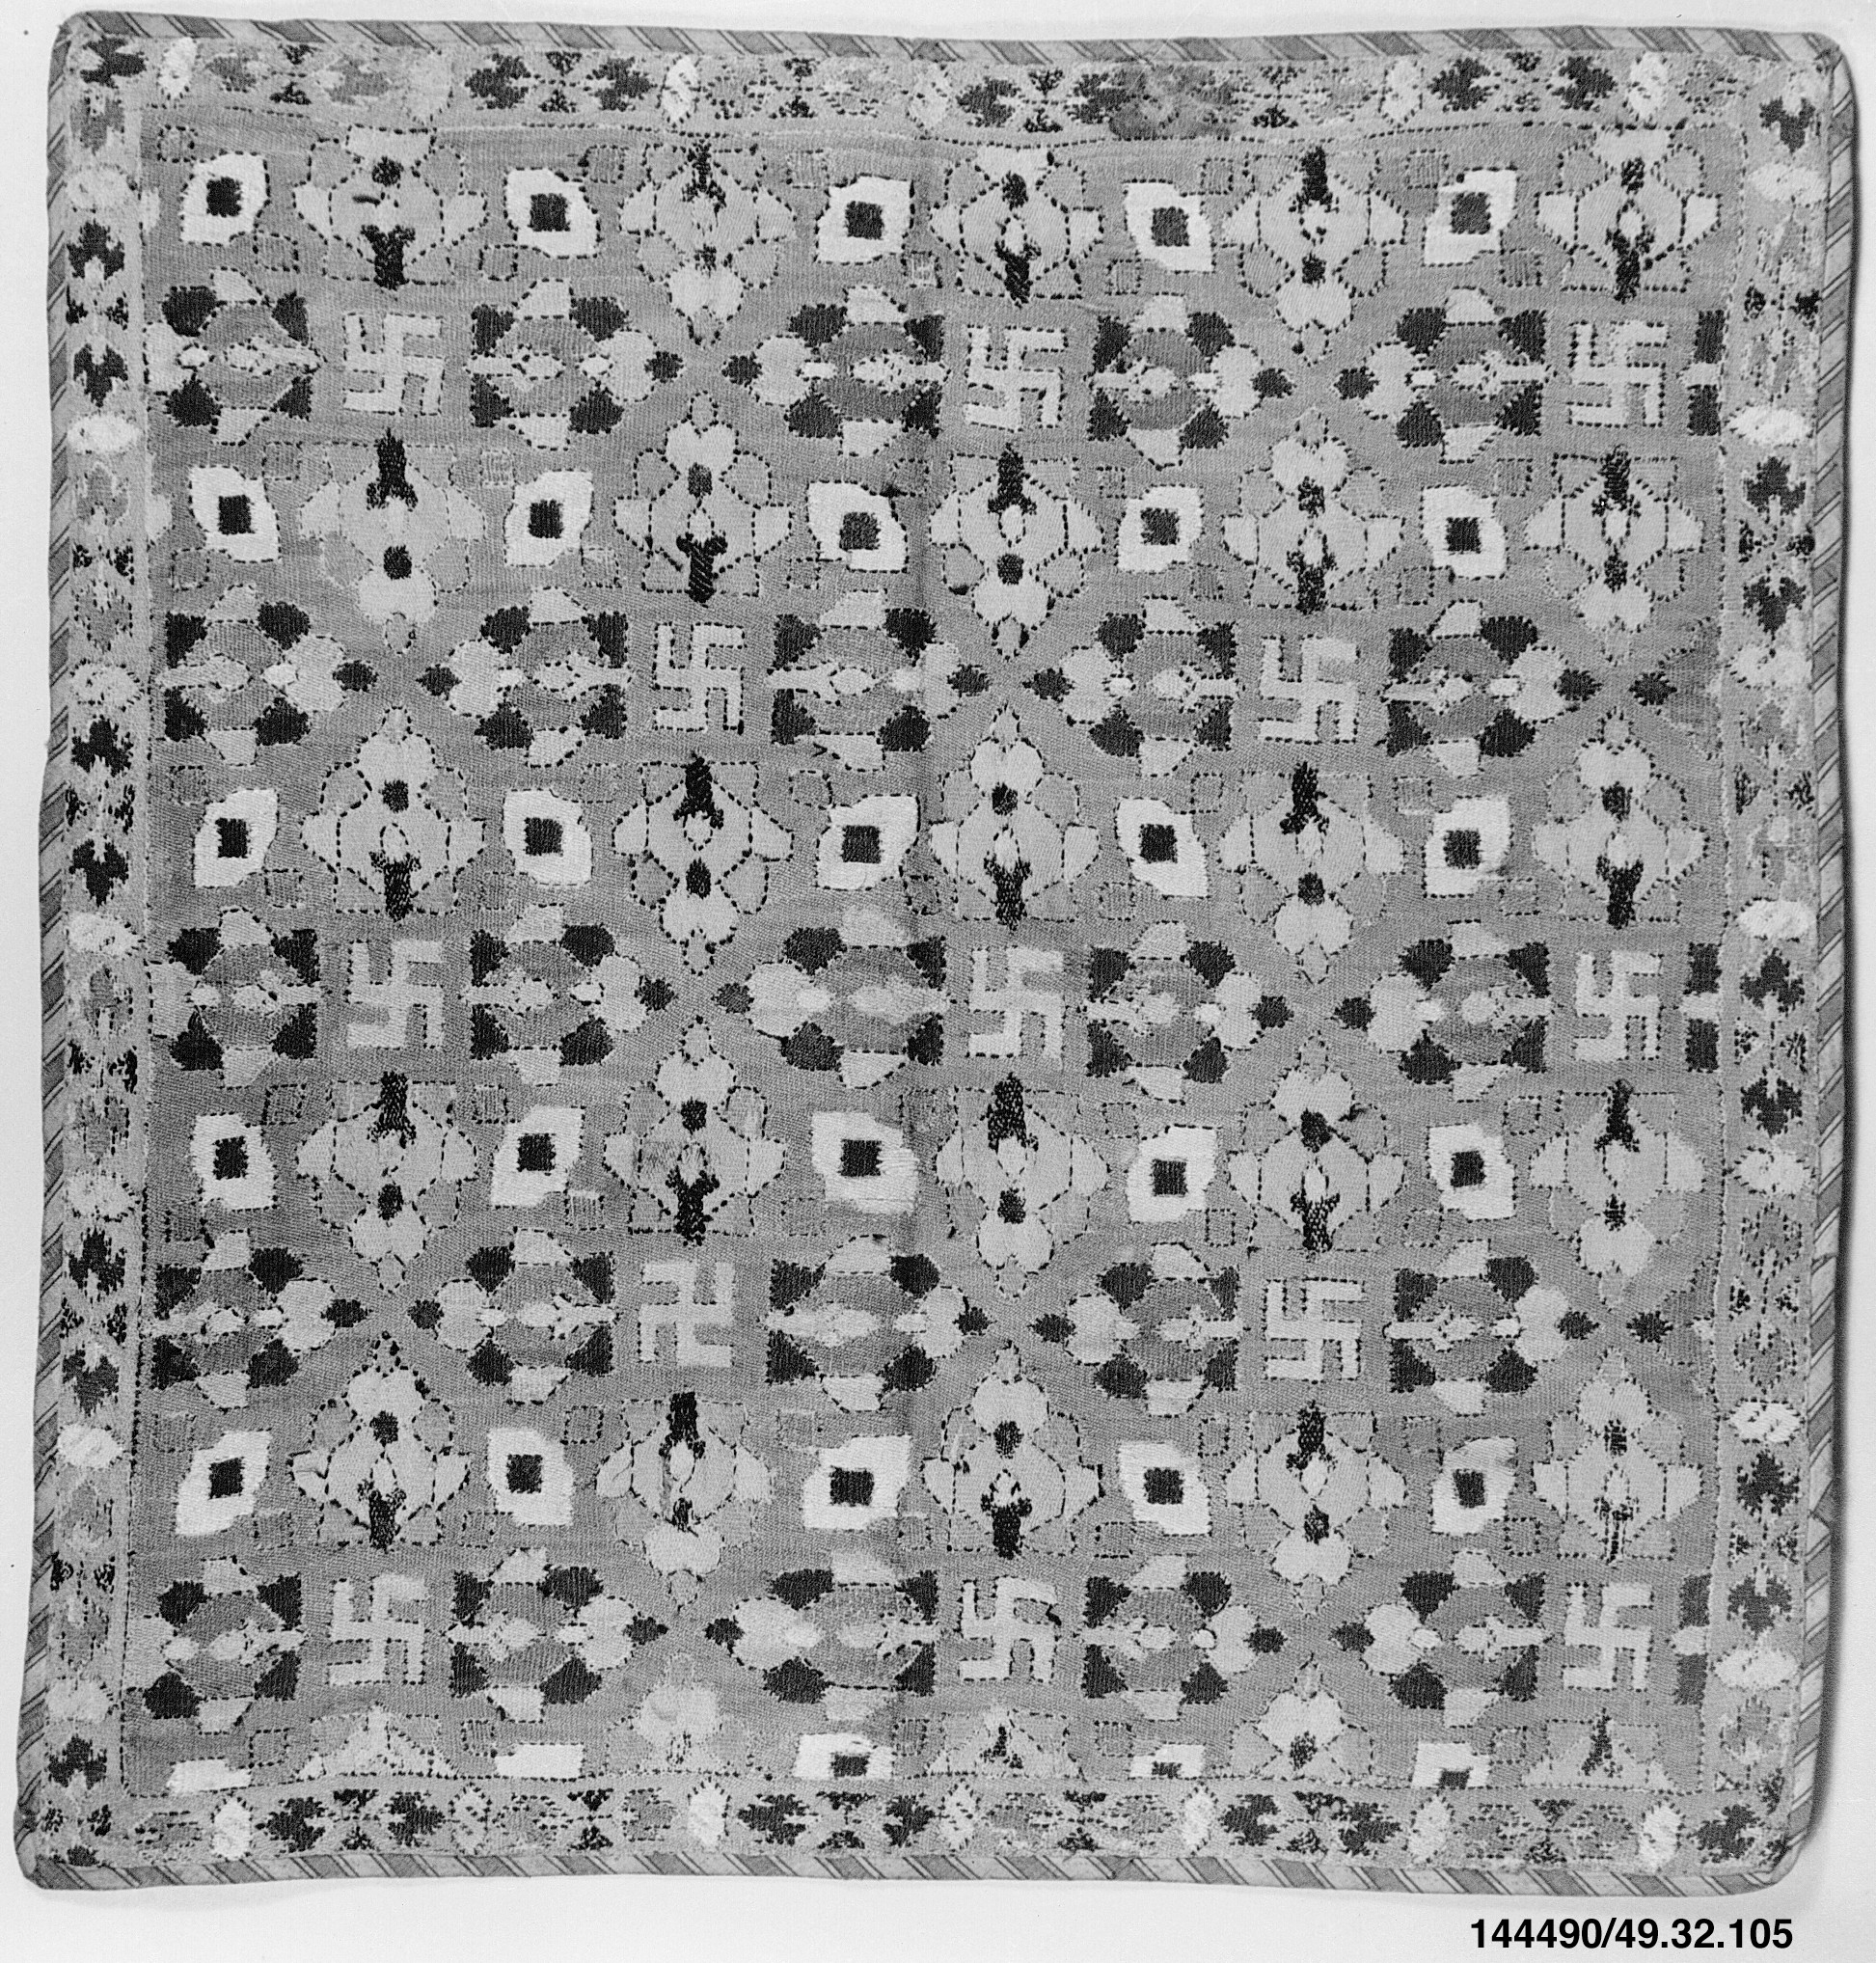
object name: cover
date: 1801-1833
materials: cotton, silk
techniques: embroidery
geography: caucasus